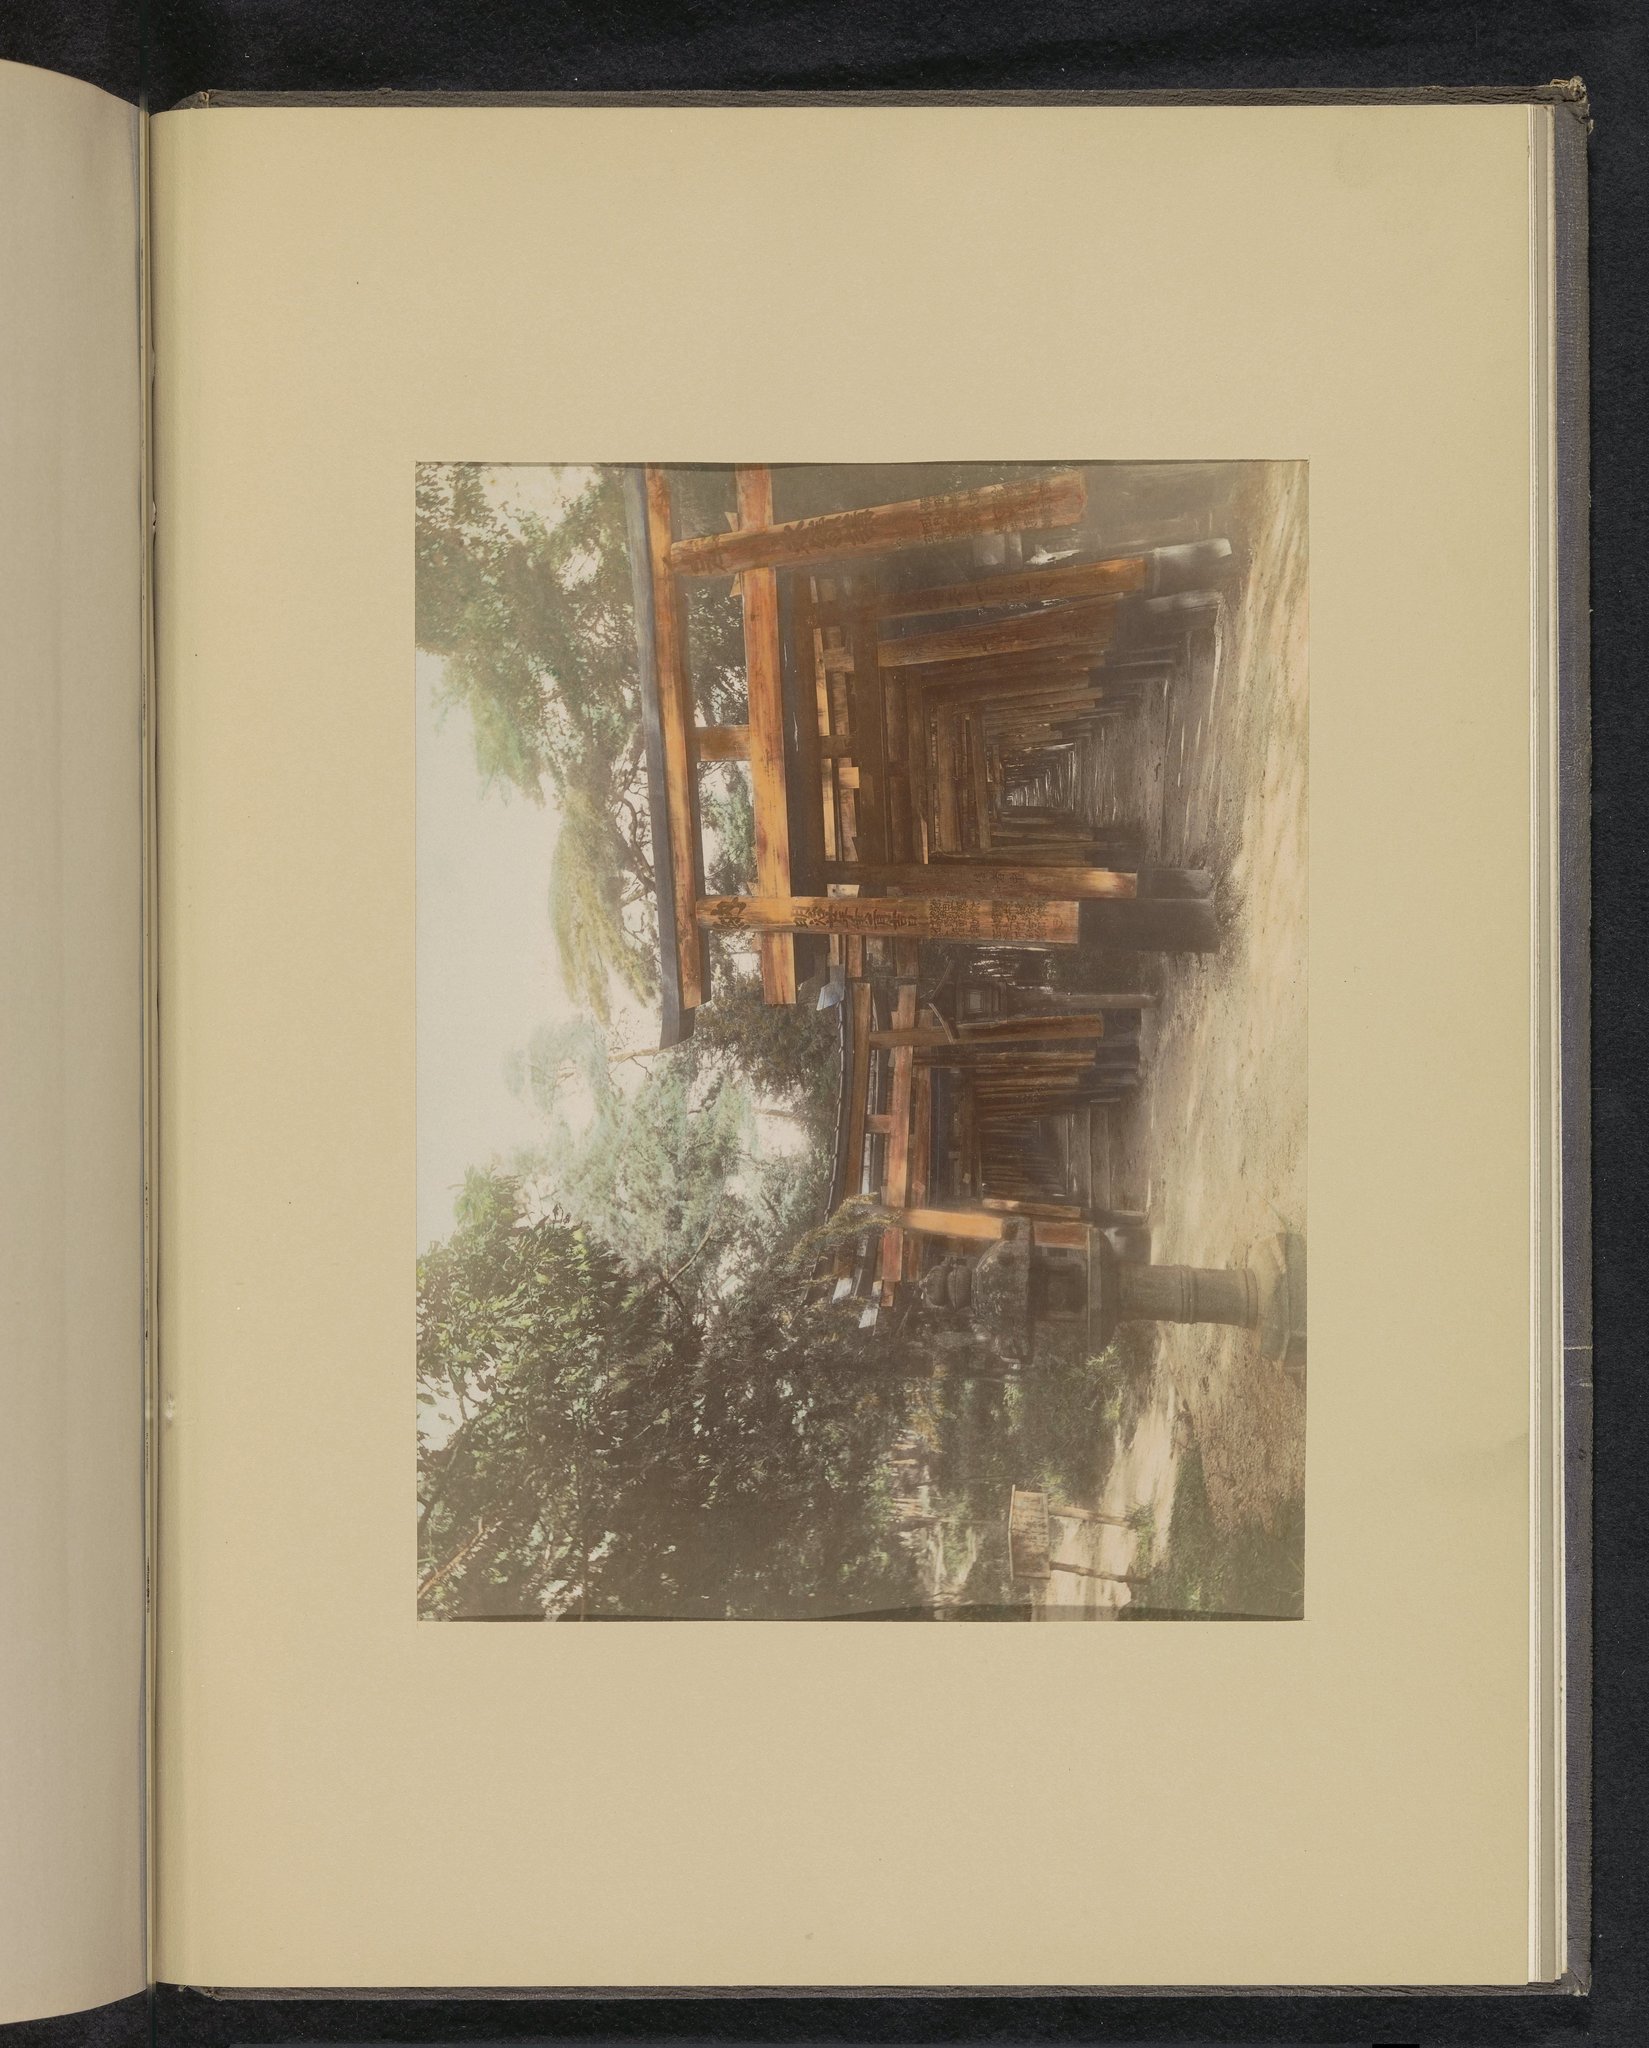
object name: photograph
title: Torii-galerij voor de tempel Fushimi Inari-taisha te Kyoto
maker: Anonymous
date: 1887-1897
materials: photographic support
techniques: albumen print, hand coloring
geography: kyoto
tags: temple, shrine ~ shinto, gate, entrance